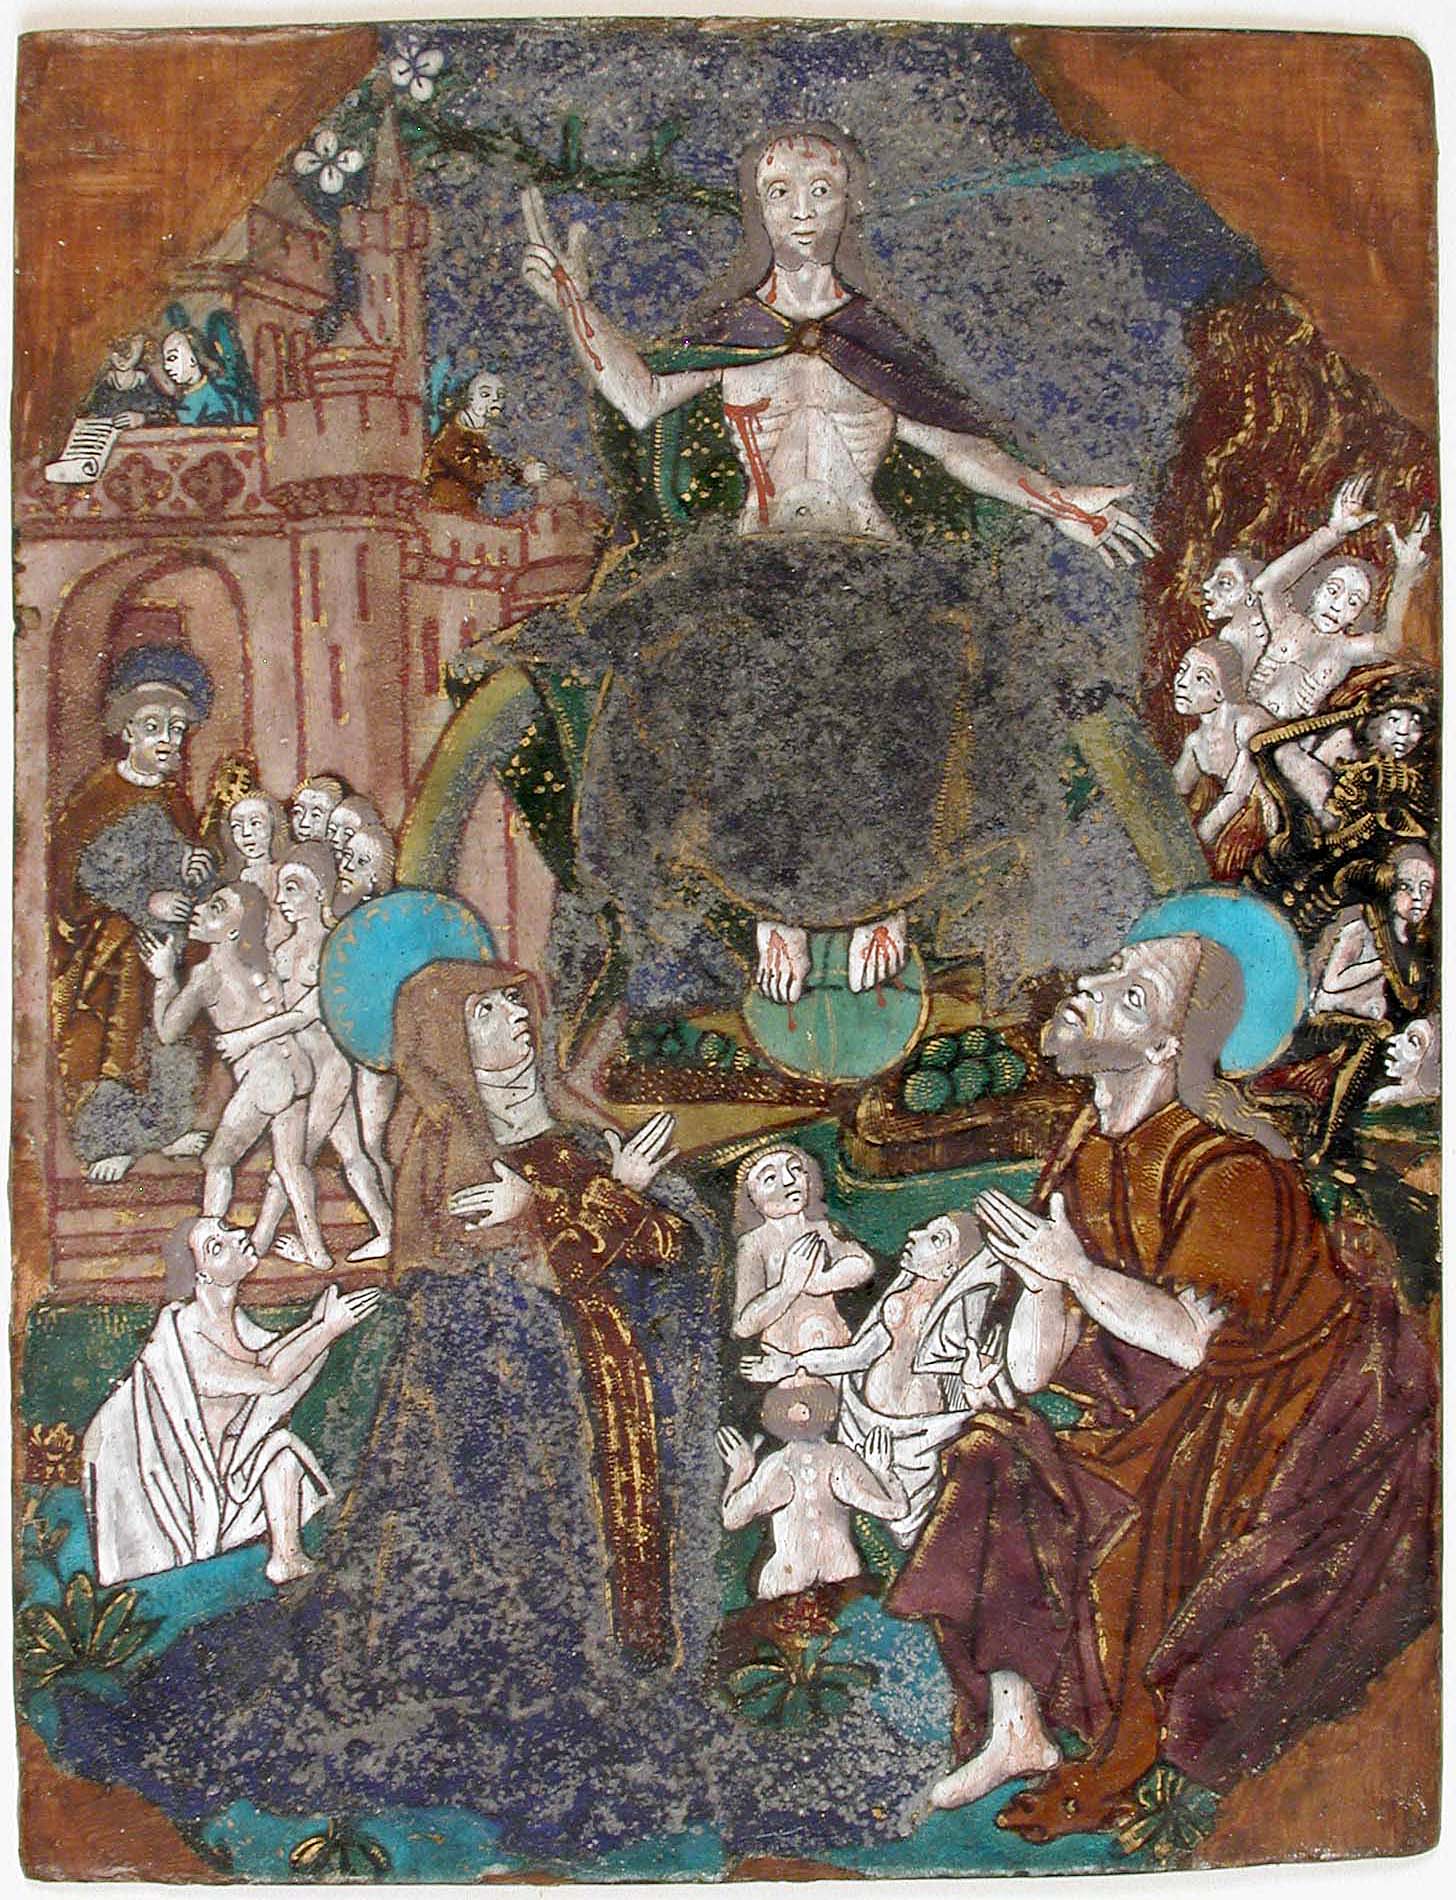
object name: plaque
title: Plaque with the Last Judgement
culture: french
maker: monvaerni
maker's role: artist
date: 1500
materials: copper, enamel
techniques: painting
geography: france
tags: christ,virgin mary,hell,last judgement